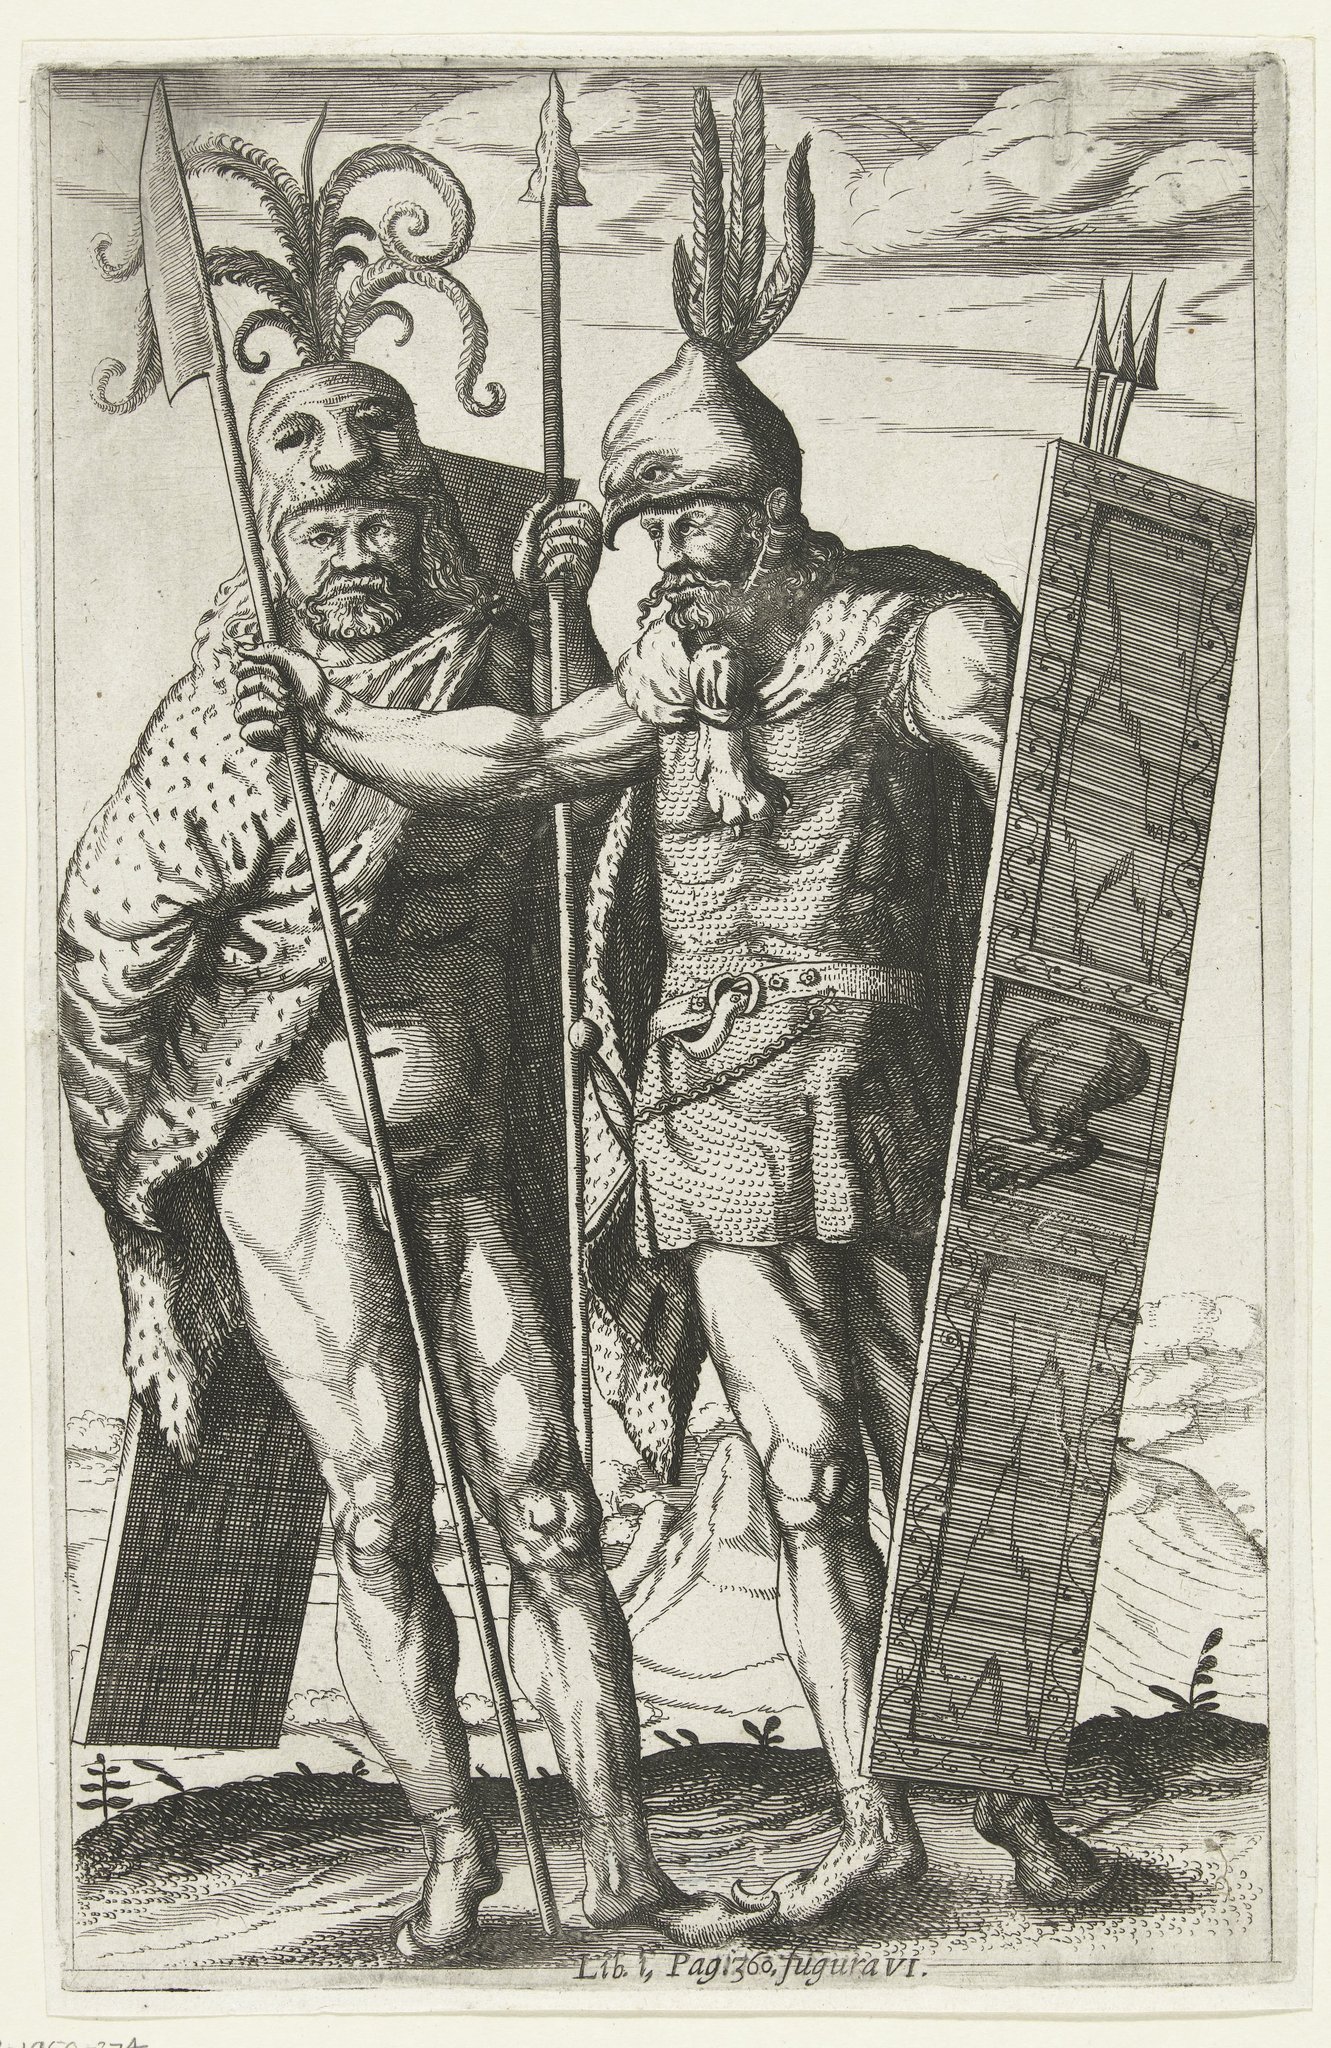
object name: print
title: Twee Germaanse krijgers, figura VI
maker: nicolaes van geelkercken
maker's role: print maker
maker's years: 1585-1656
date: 1614-1616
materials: paper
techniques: etching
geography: netherlands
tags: the soldier; the soldier's life, extinct, 'historical' peoples (with name)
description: Twee staande krijgslieden met speren, schilden en gepluimde helmen. Afkomstig uit: Philippus Cluverius, Germaniæ antiquæ libri tres, Lowijs (I) Elzevier, Leiden, 1616. Lib. I, Pag. 360, figura VI.